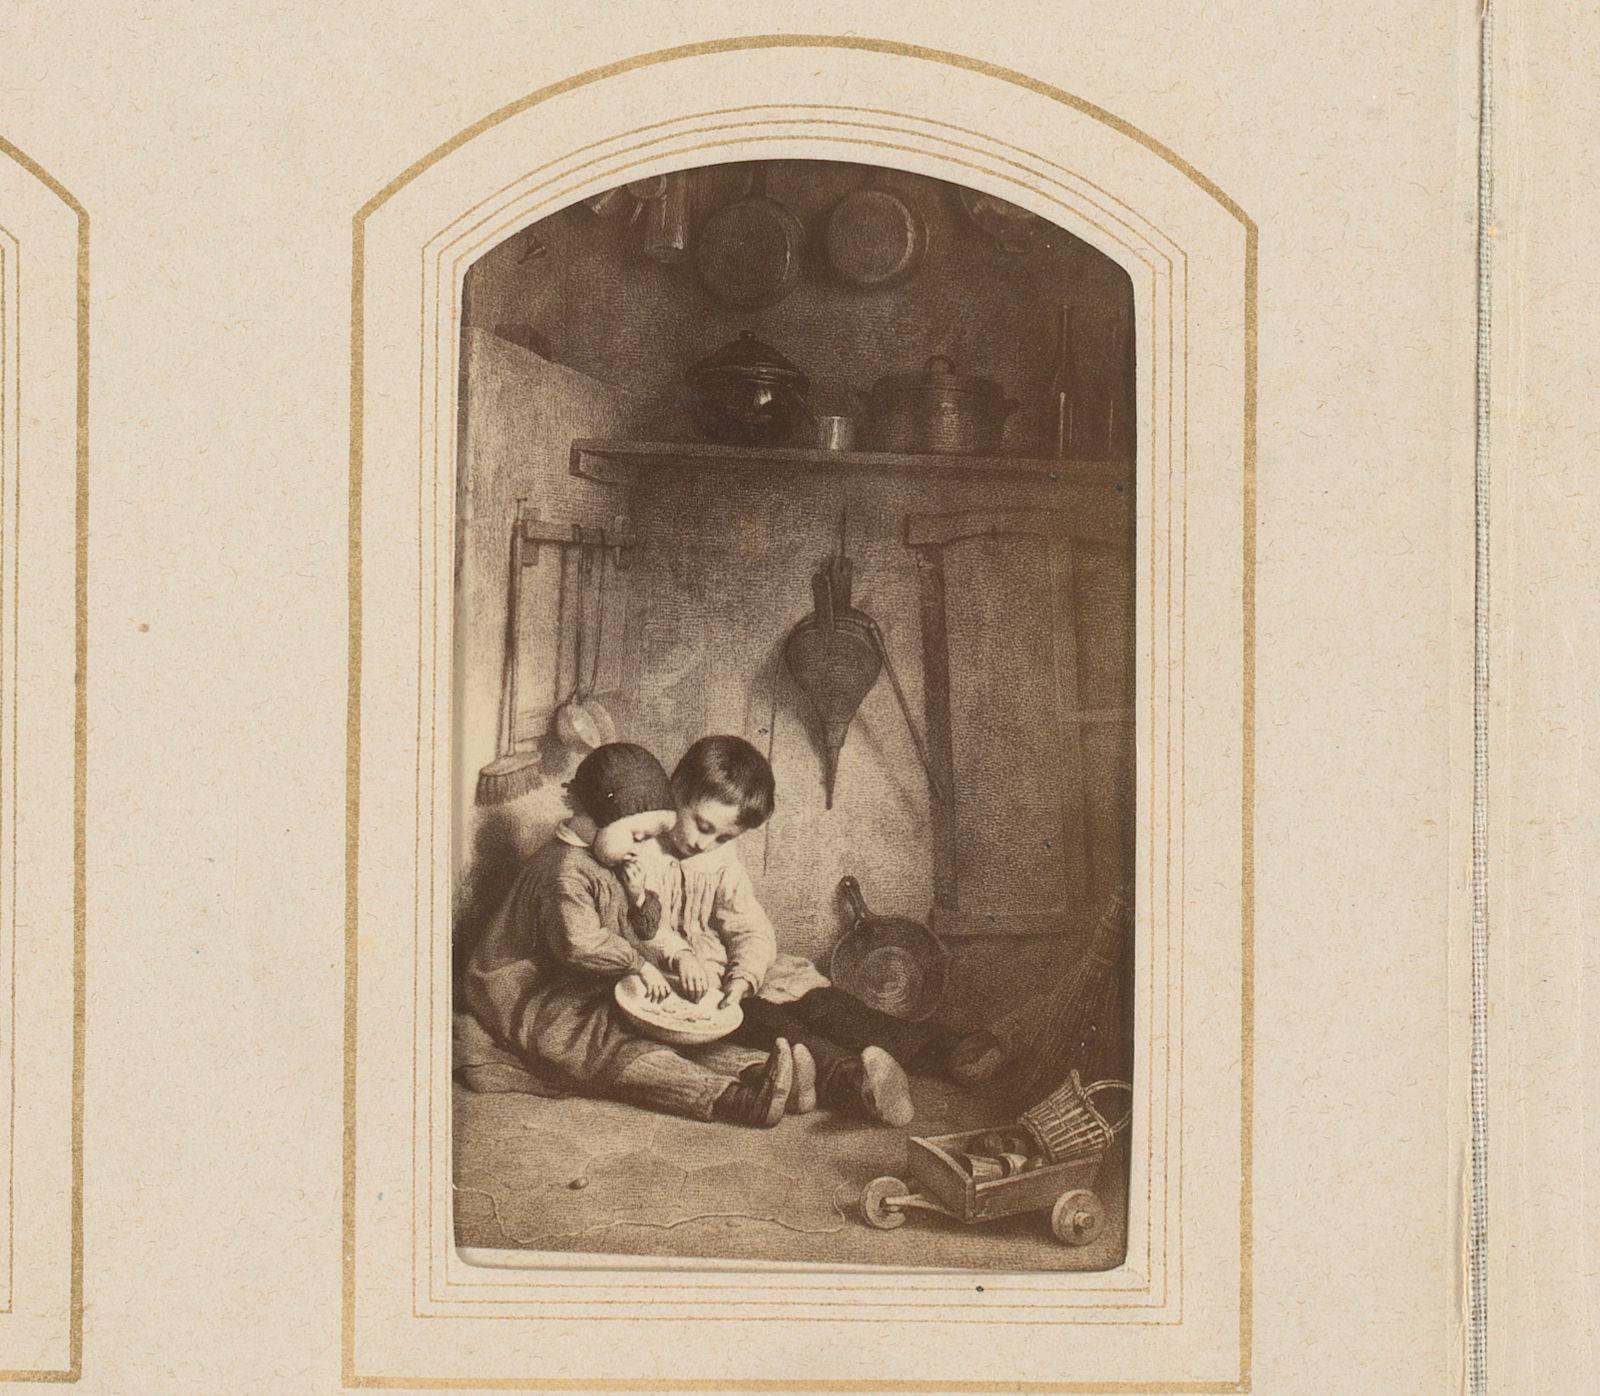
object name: photograph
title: Fotoreproductie van Les mies de gateau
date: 1870-1900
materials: cardboard, photographic support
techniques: albumen print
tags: child, interior of the house, painting, drawing and the graphic arts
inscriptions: inscription: ‘1203/ Collection moderne./ E. Frère/ Les nies de gâteau./ Die kuchenkrümel.’, annotation: ‘Die kuchenkrümmel’